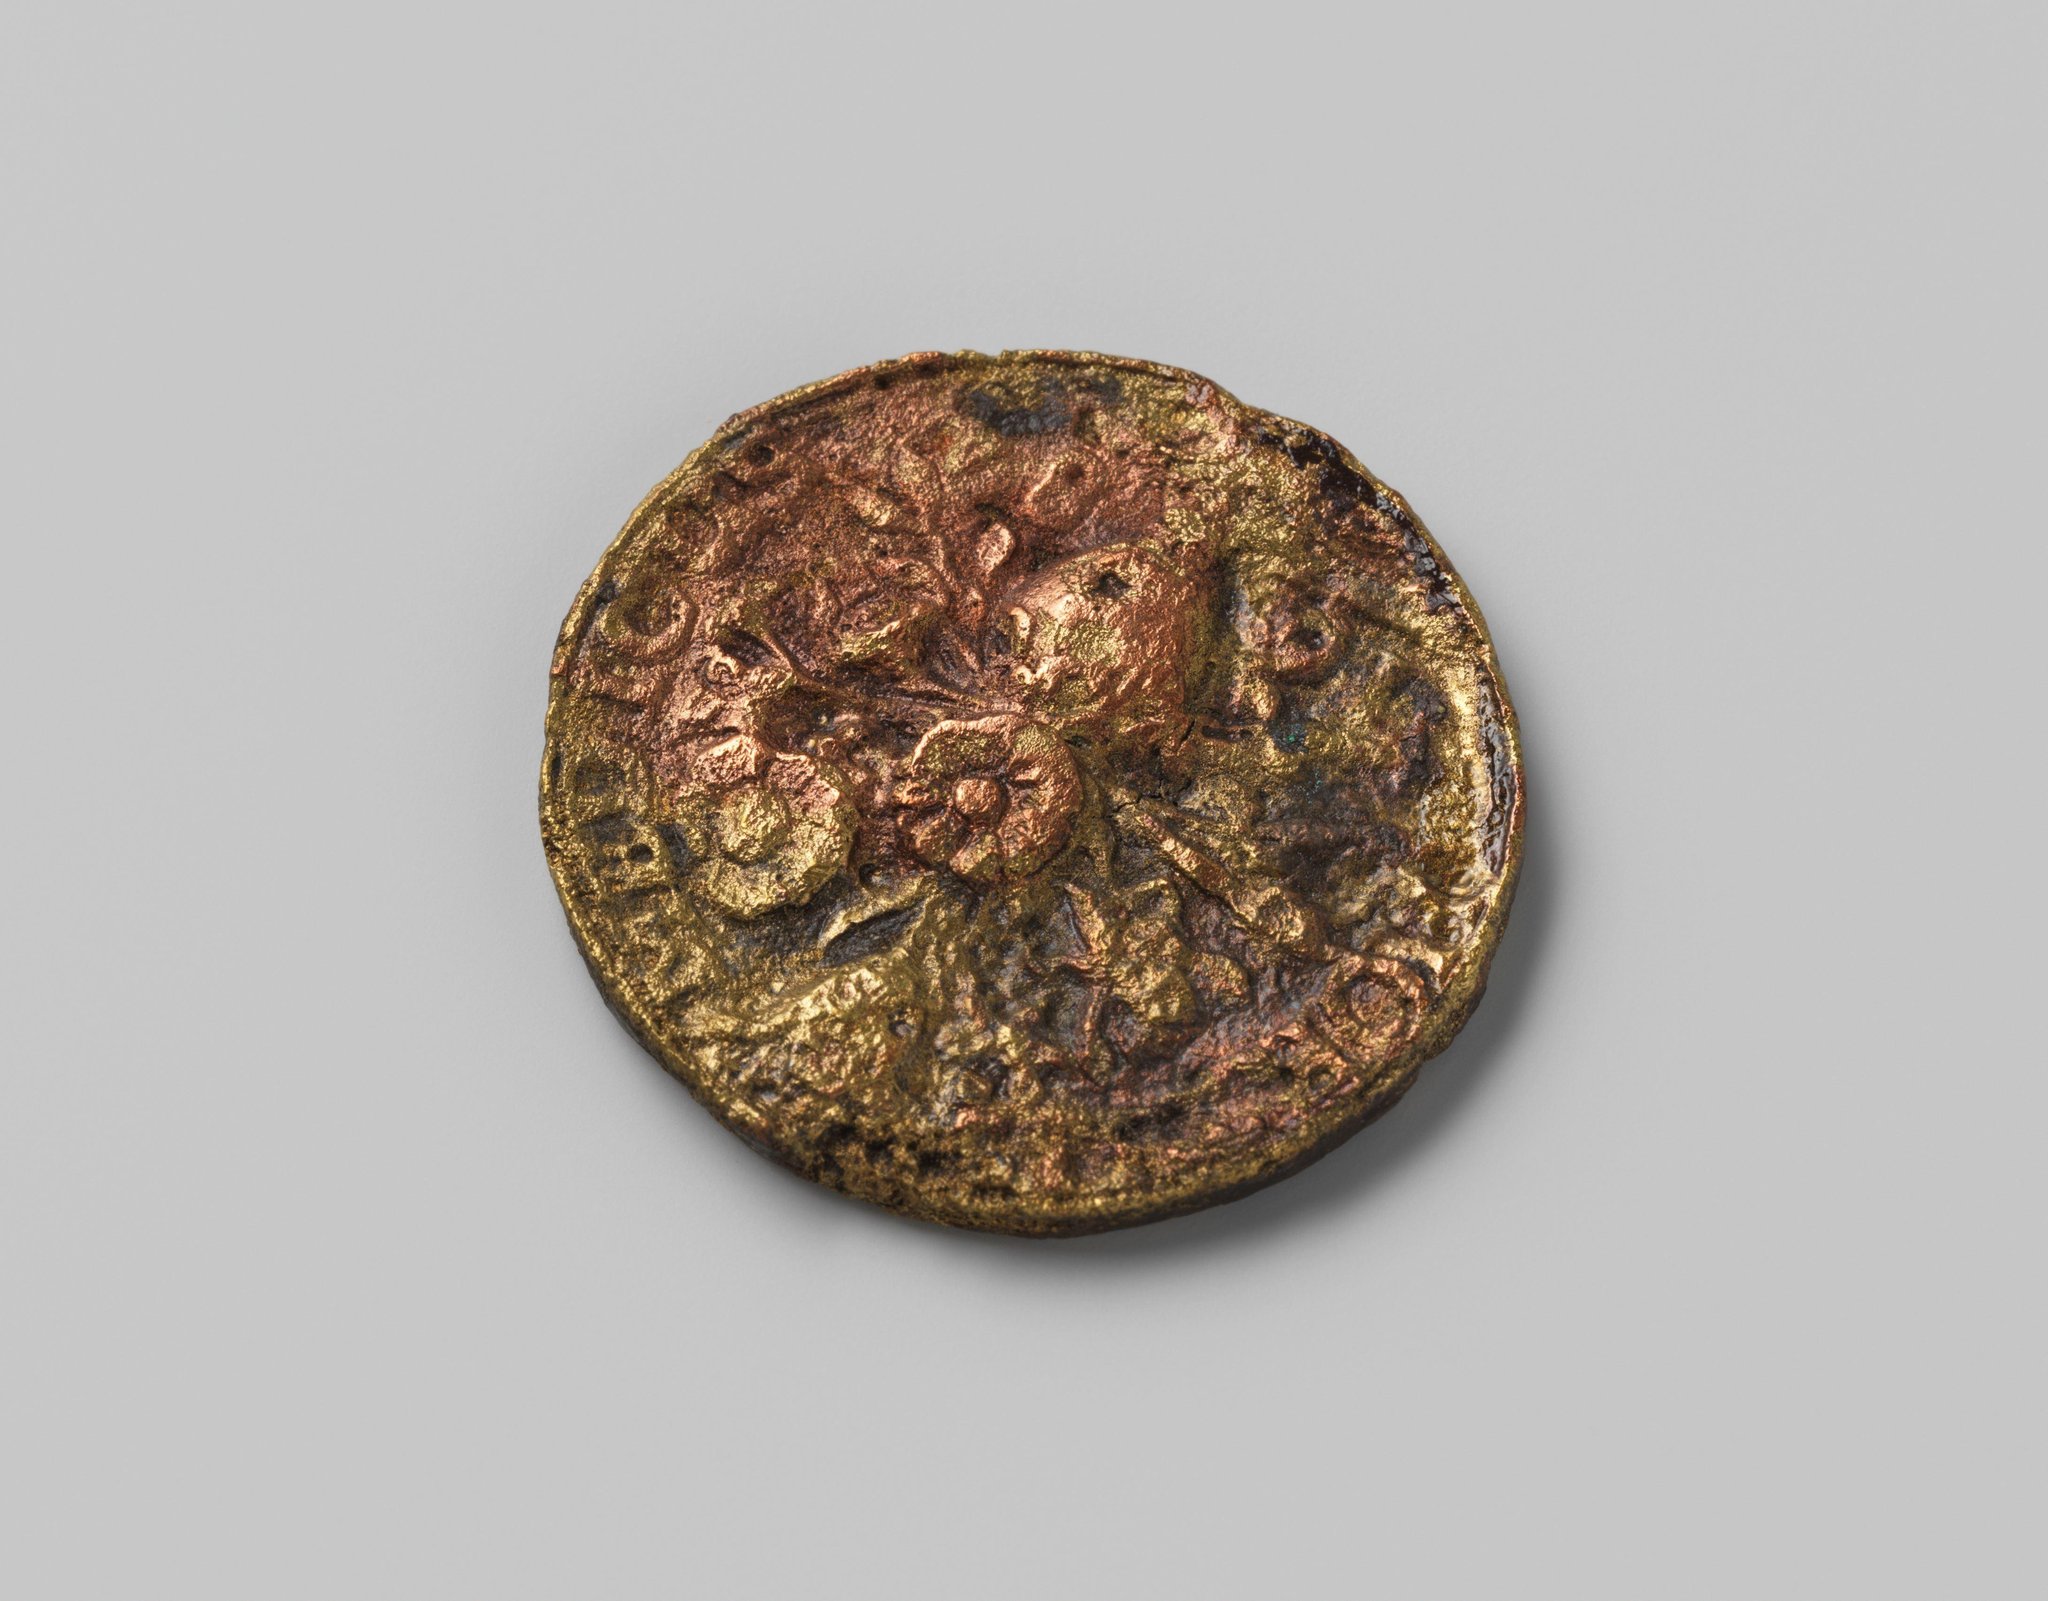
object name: toegangspenning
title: Toegangspenning van het Collegium Medicum te Amsterdam uit het wrak van de Oost-Indiëvaarder Hollandia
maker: Anonymous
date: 1700-1743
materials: copper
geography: netherlands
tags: amsterdam